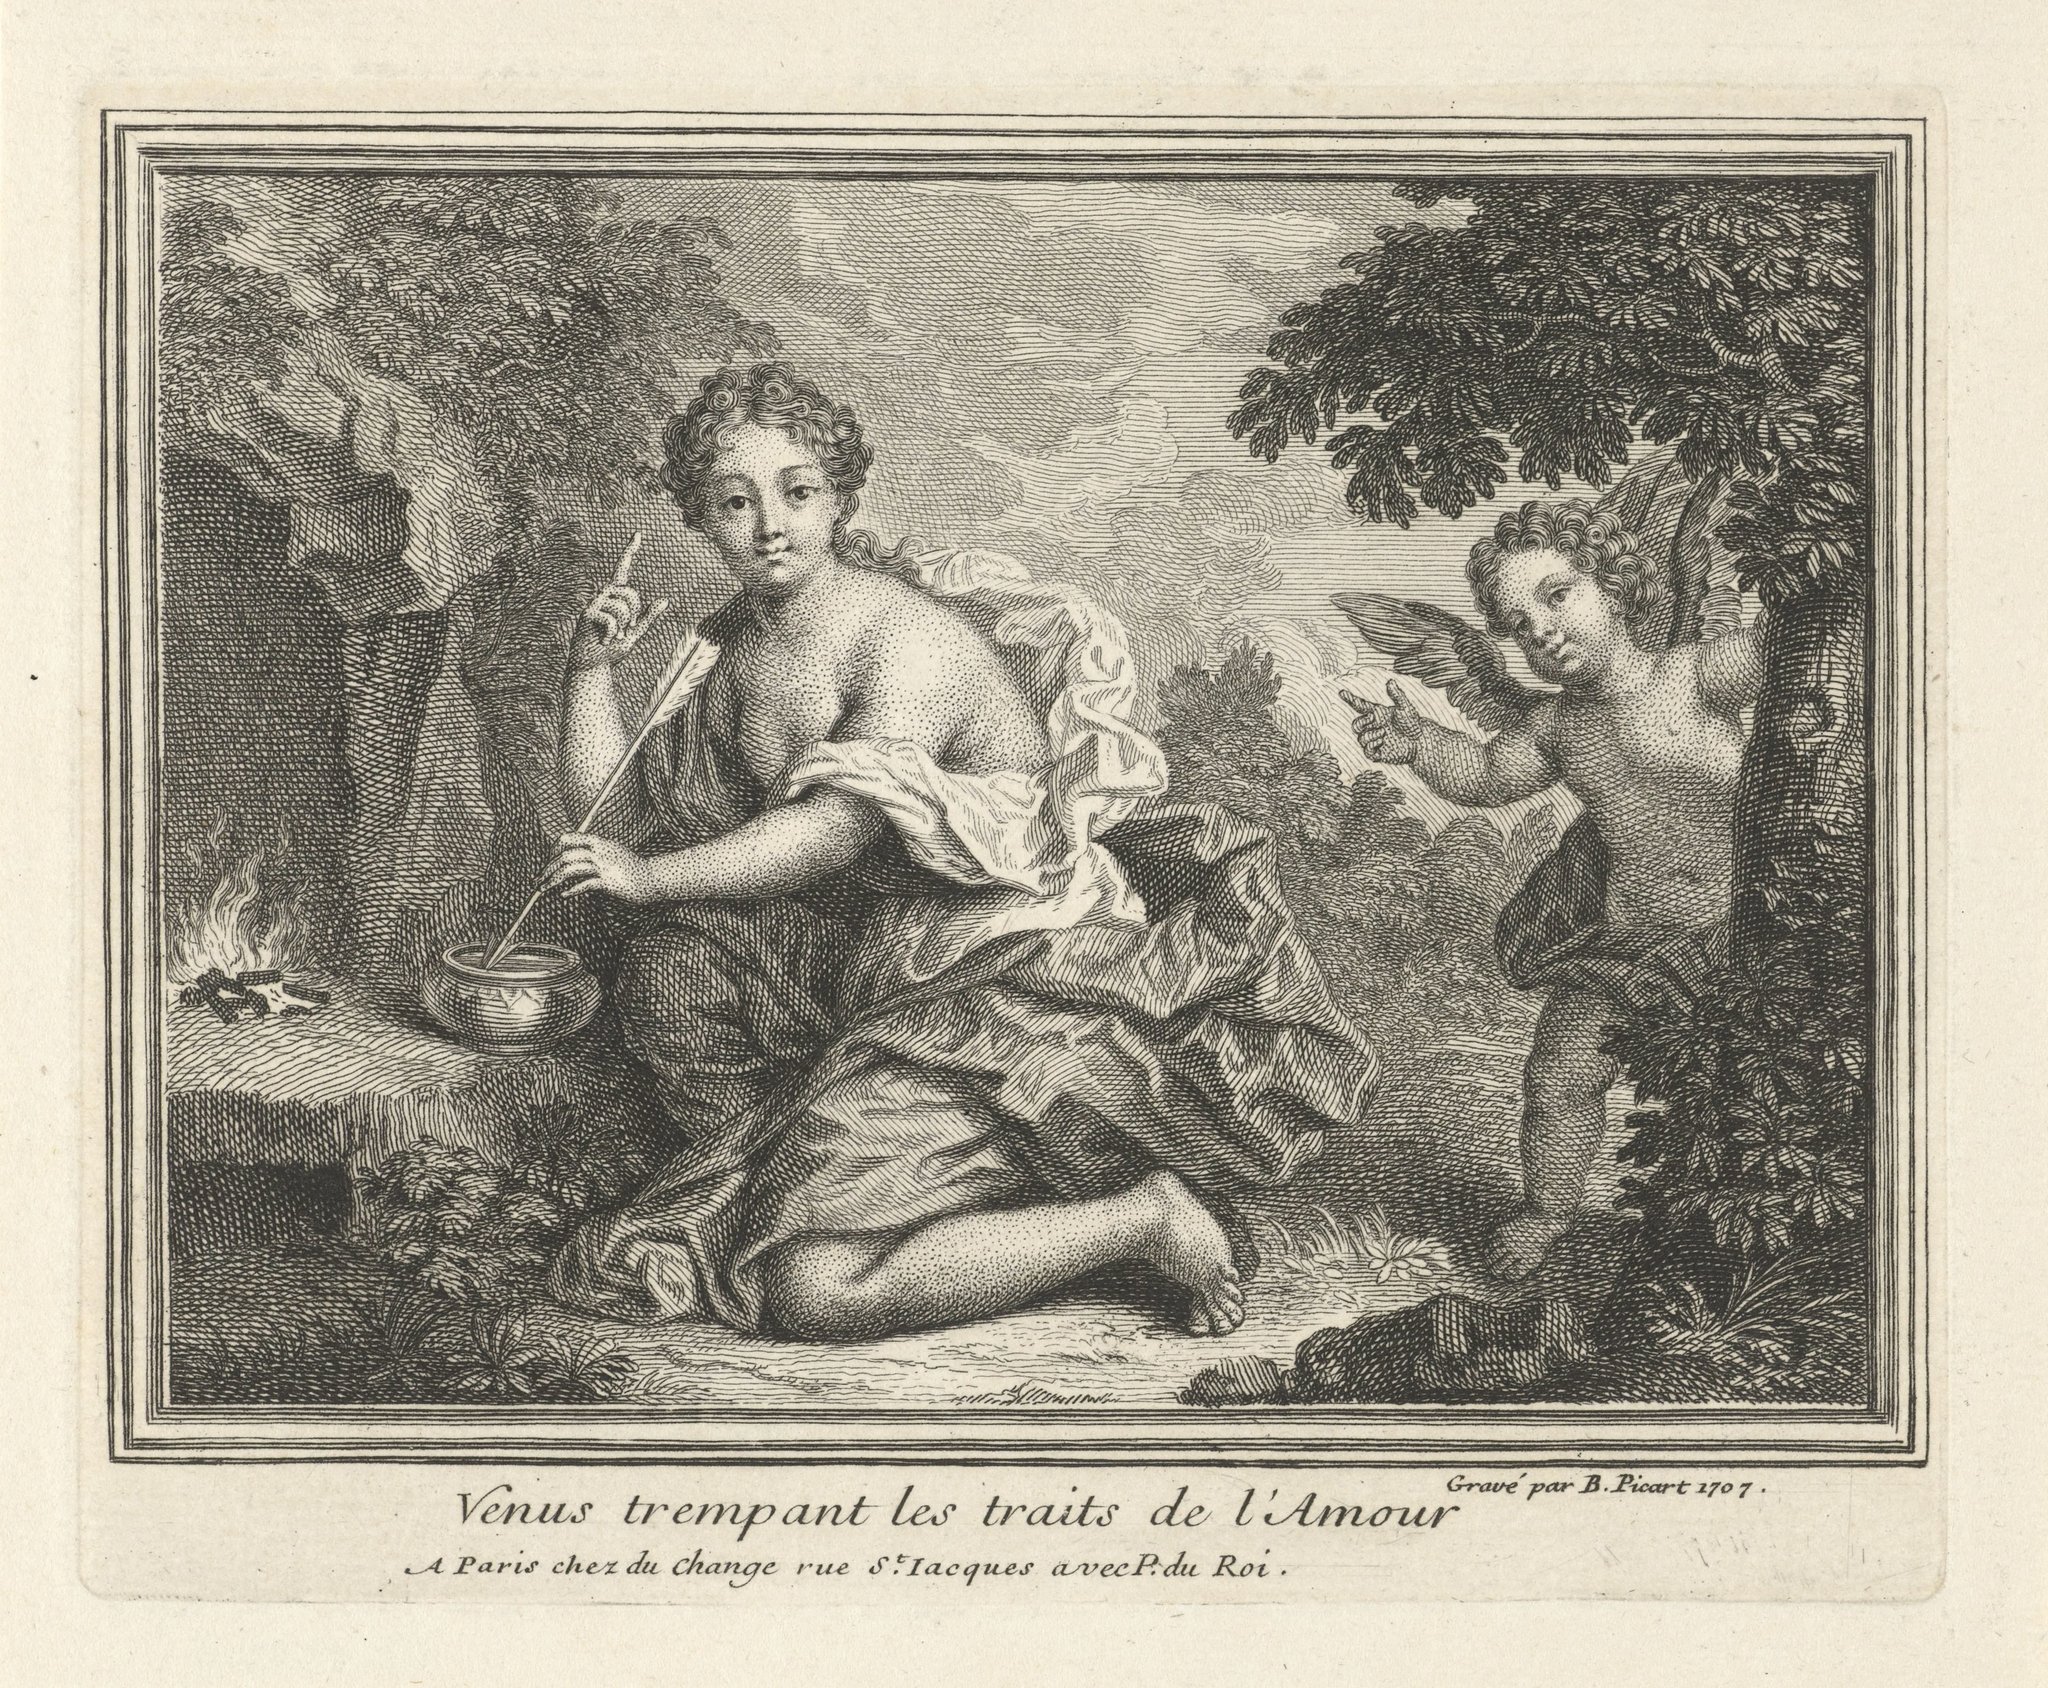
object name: print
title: Venus met de pijlen van Amor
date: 1707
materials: paper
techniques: engraving, etching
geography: paris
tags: venus taking care of cupid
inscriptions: collector's mark: Lugt 2228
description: Landschap met Venus die de pijlen van Amor in een vuurpot houdt. Amor kijkt toe vanachter een boom.